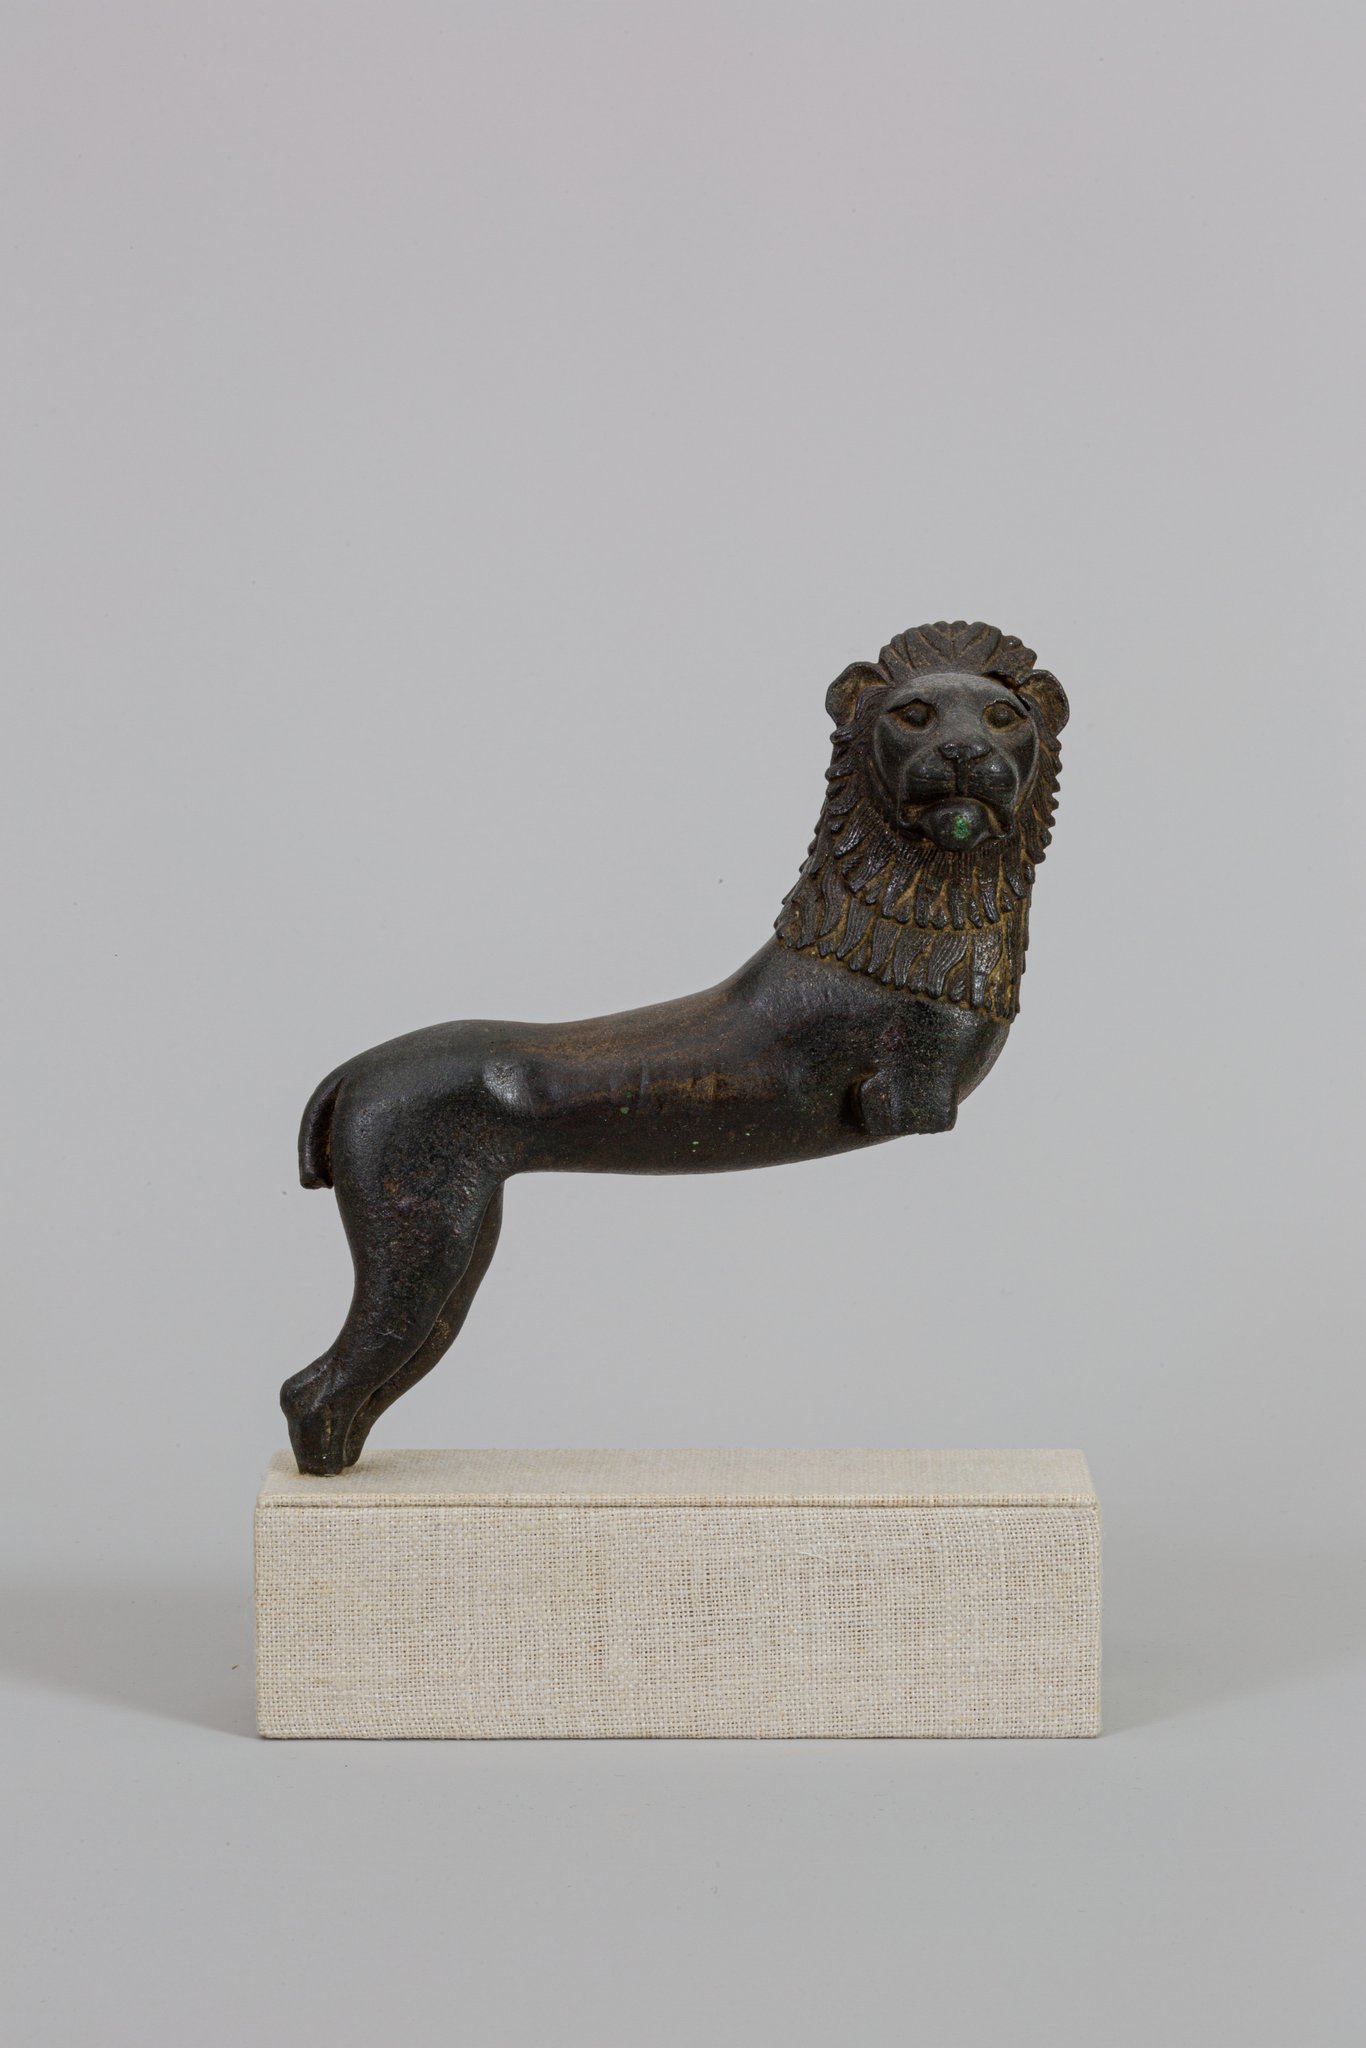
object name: statuette of a lion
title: Bronze statuette of a lion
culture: greek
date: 534-501 BCE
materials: bronze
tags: lions